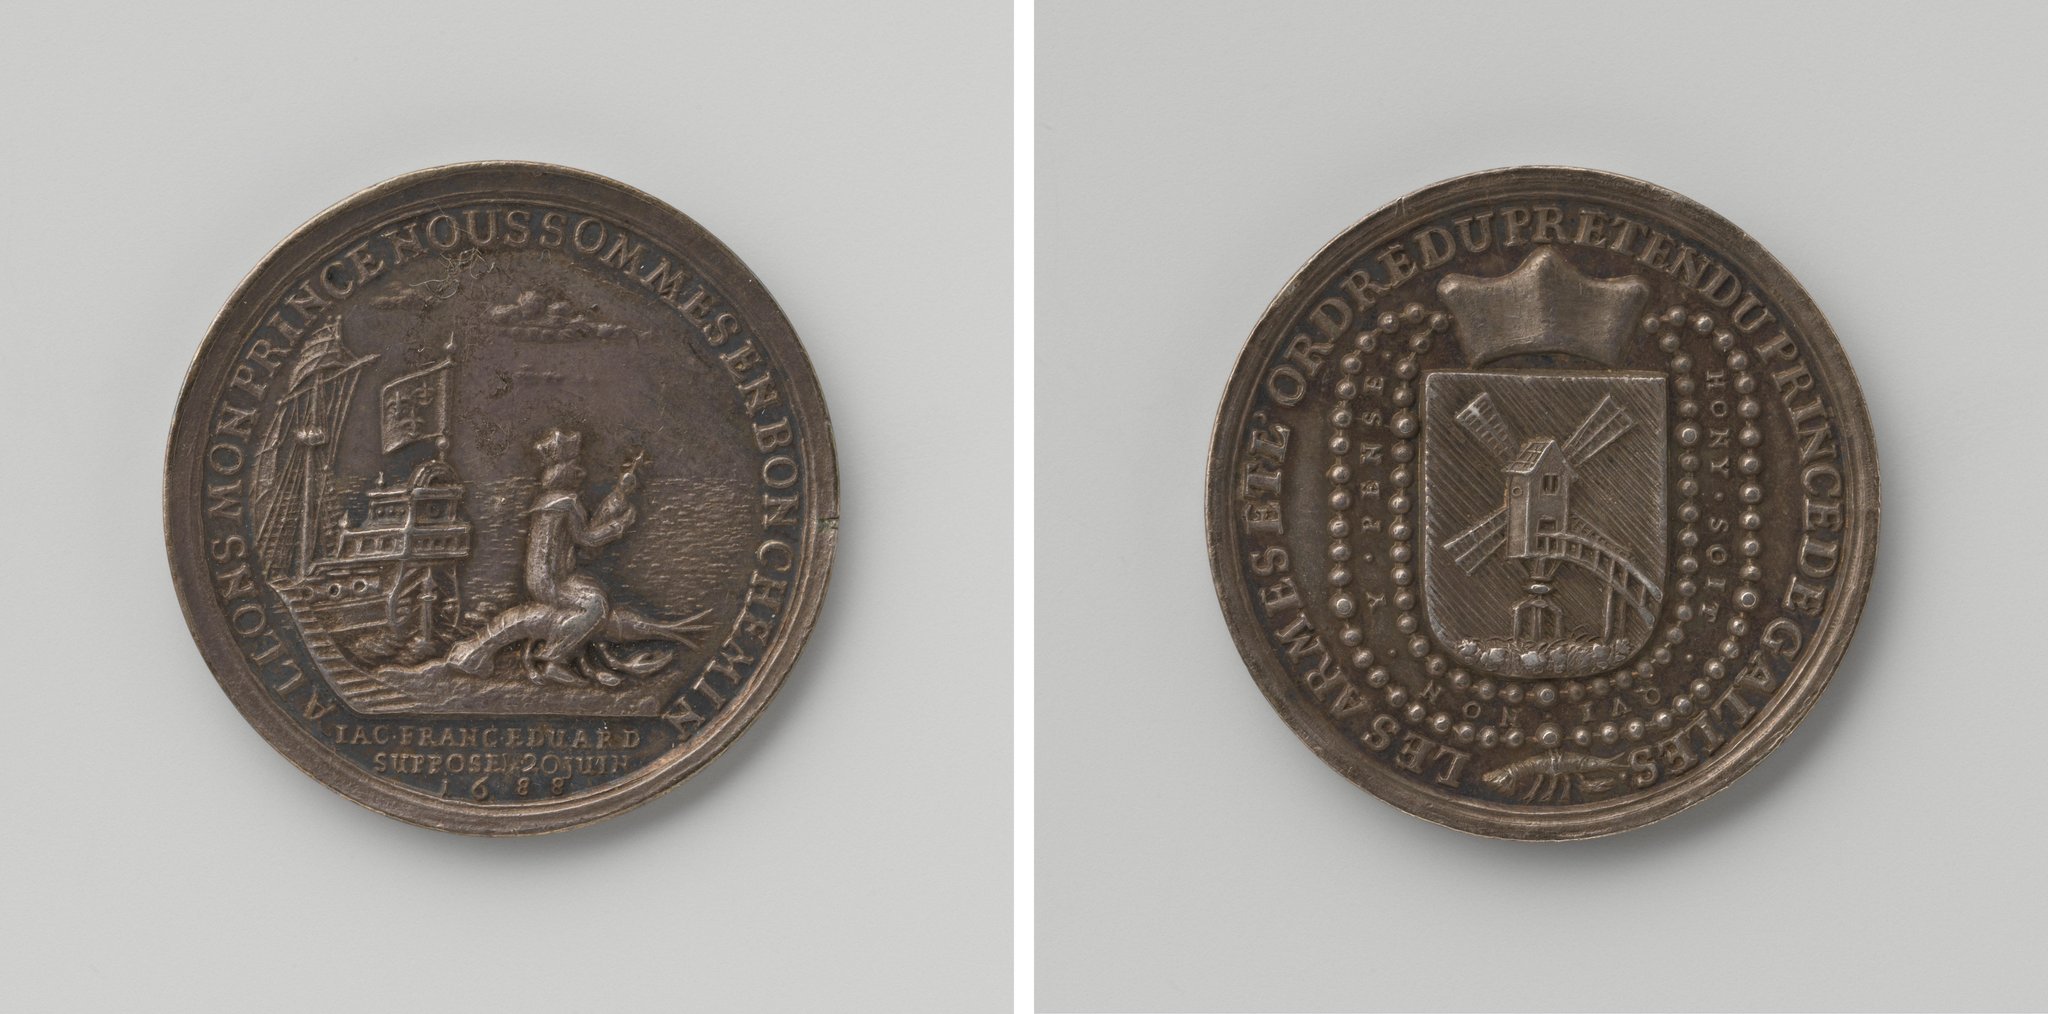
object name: satirical medal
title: Vlucht van Jacobus Frans Eduard, prins van Wales naar Frankrijk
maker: christian wermuth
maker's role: medailleur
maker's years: 1661-1739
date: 1688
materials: silver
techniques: striking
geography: gotha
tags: france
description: Zilveren penning. Voorzijde: Jezuit met prins van Wales in armen zittend op zeekreeft, op achtergrond schip waarmee koningin vluchtte binnen omschrift; afsnede: opschrift. Keerzijde: met Jezuitenmuts bekroond wapenschild waarop windmolen staat afgebeeld binnen omschrift en rozekrans met onderaan kreeft binnen omschrift.